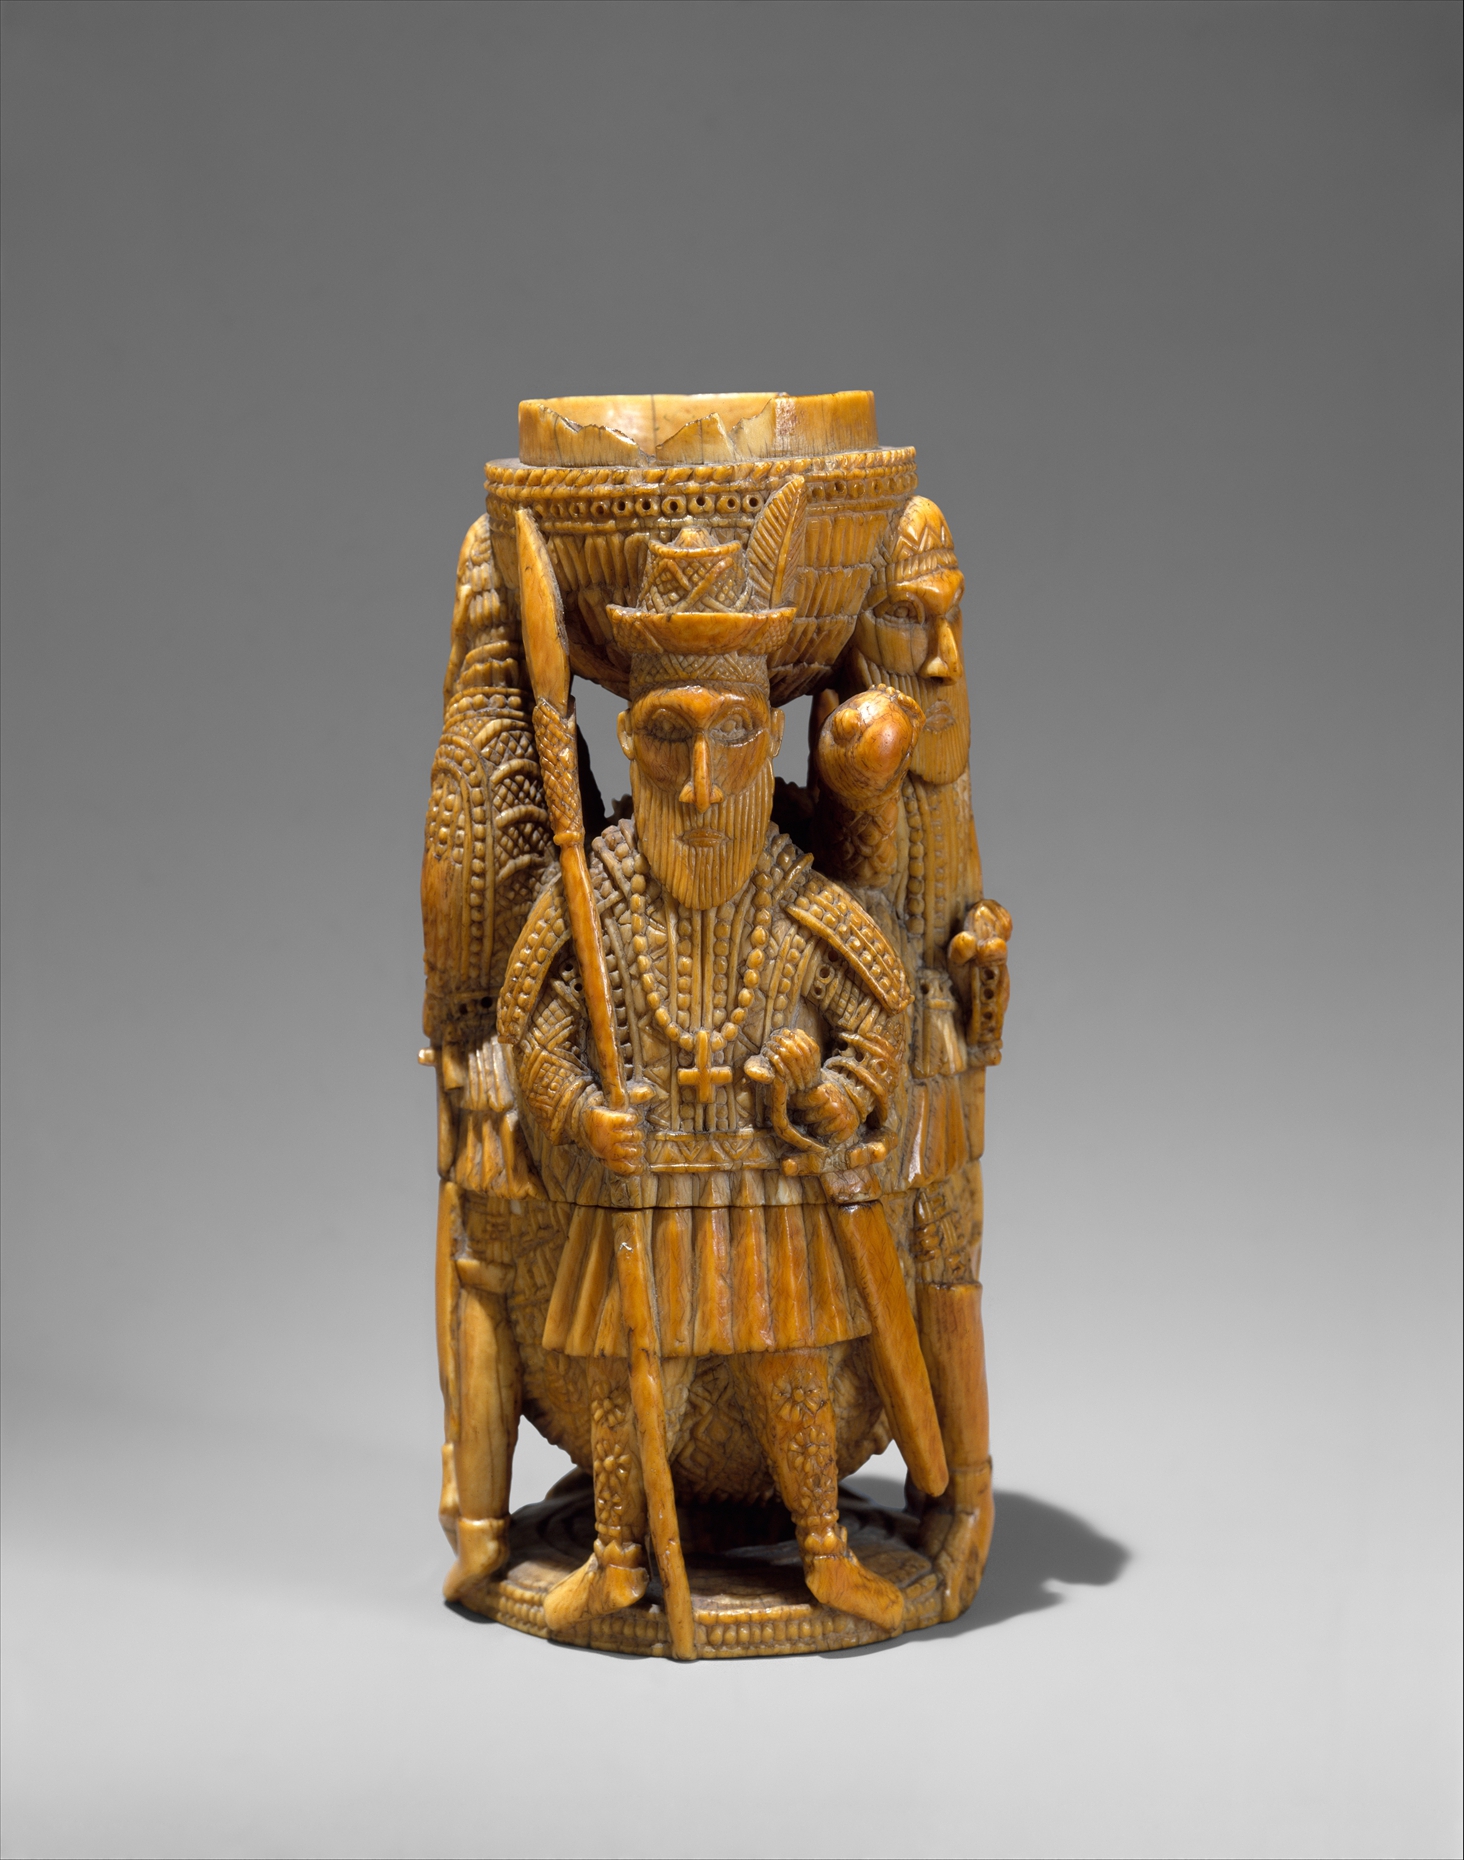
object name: saltcellar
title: Saltcellar with Portuguese Figures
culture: edo period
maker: master of the heraldic ship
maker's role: artist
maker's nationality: nigerian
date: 1525-1600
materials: ivory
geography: nigeria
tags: spears,swords,men